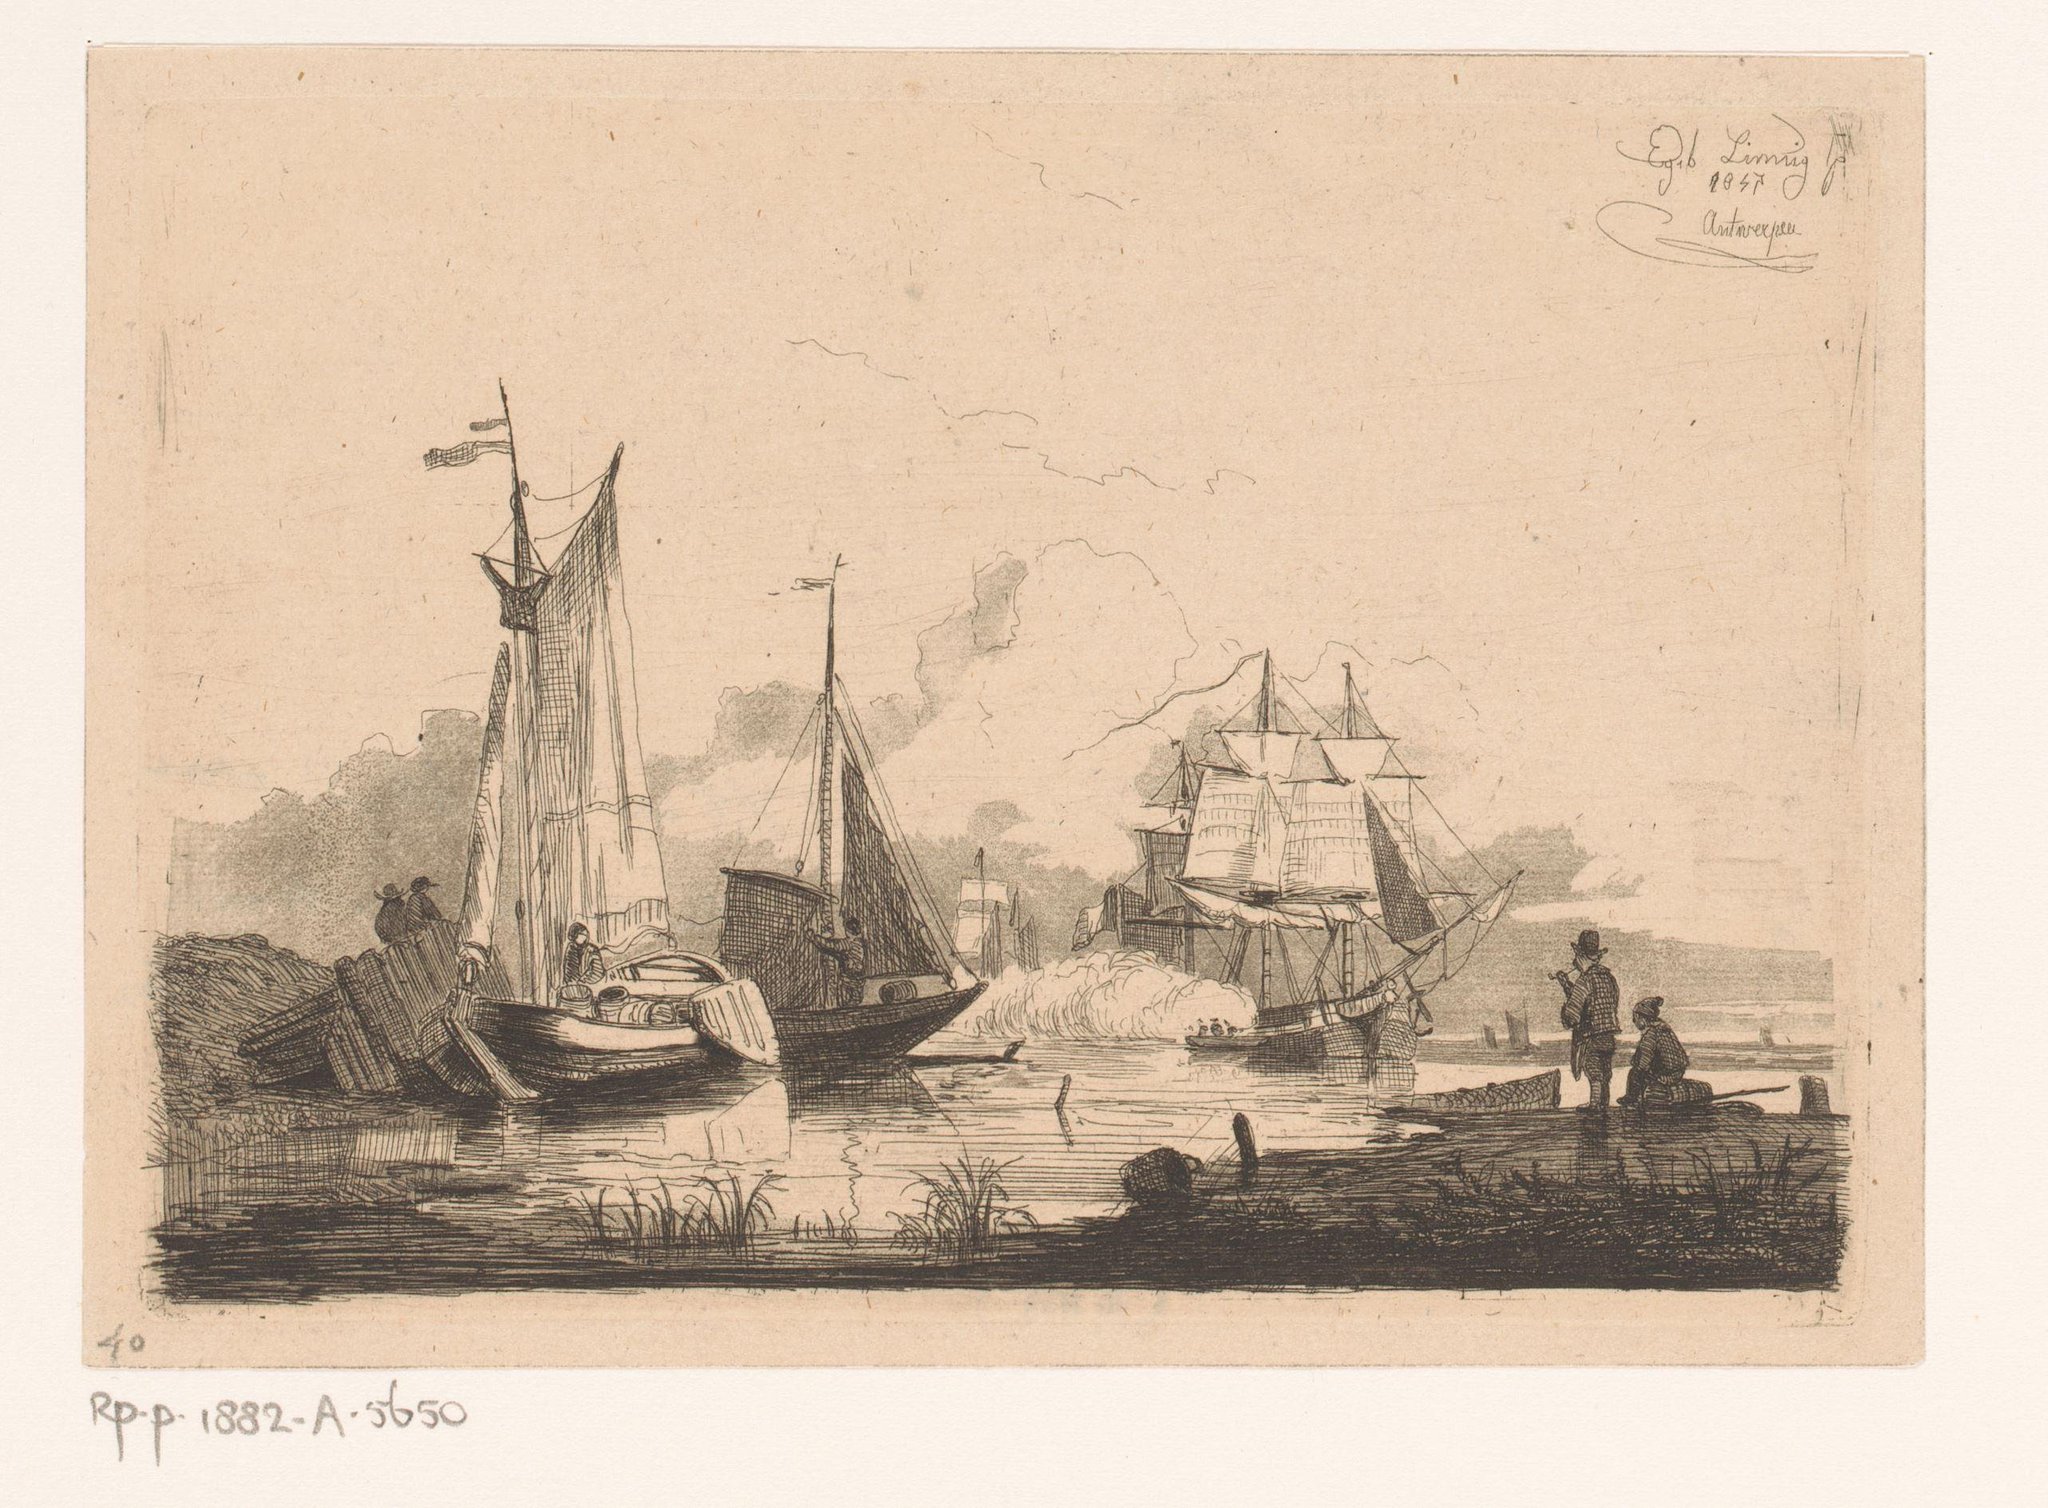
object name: print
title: Saluutschoten bij het uitzeilen van de driemaster Macassar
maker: egidius linnig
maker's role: draughtsman, print maker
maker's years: 1821-1860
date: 1847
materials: paper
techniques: aquatint, etching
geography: antwerp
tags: sailing-ship, sailing-boat, firearms: cannon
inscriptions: collector's mark: Lugt 2228